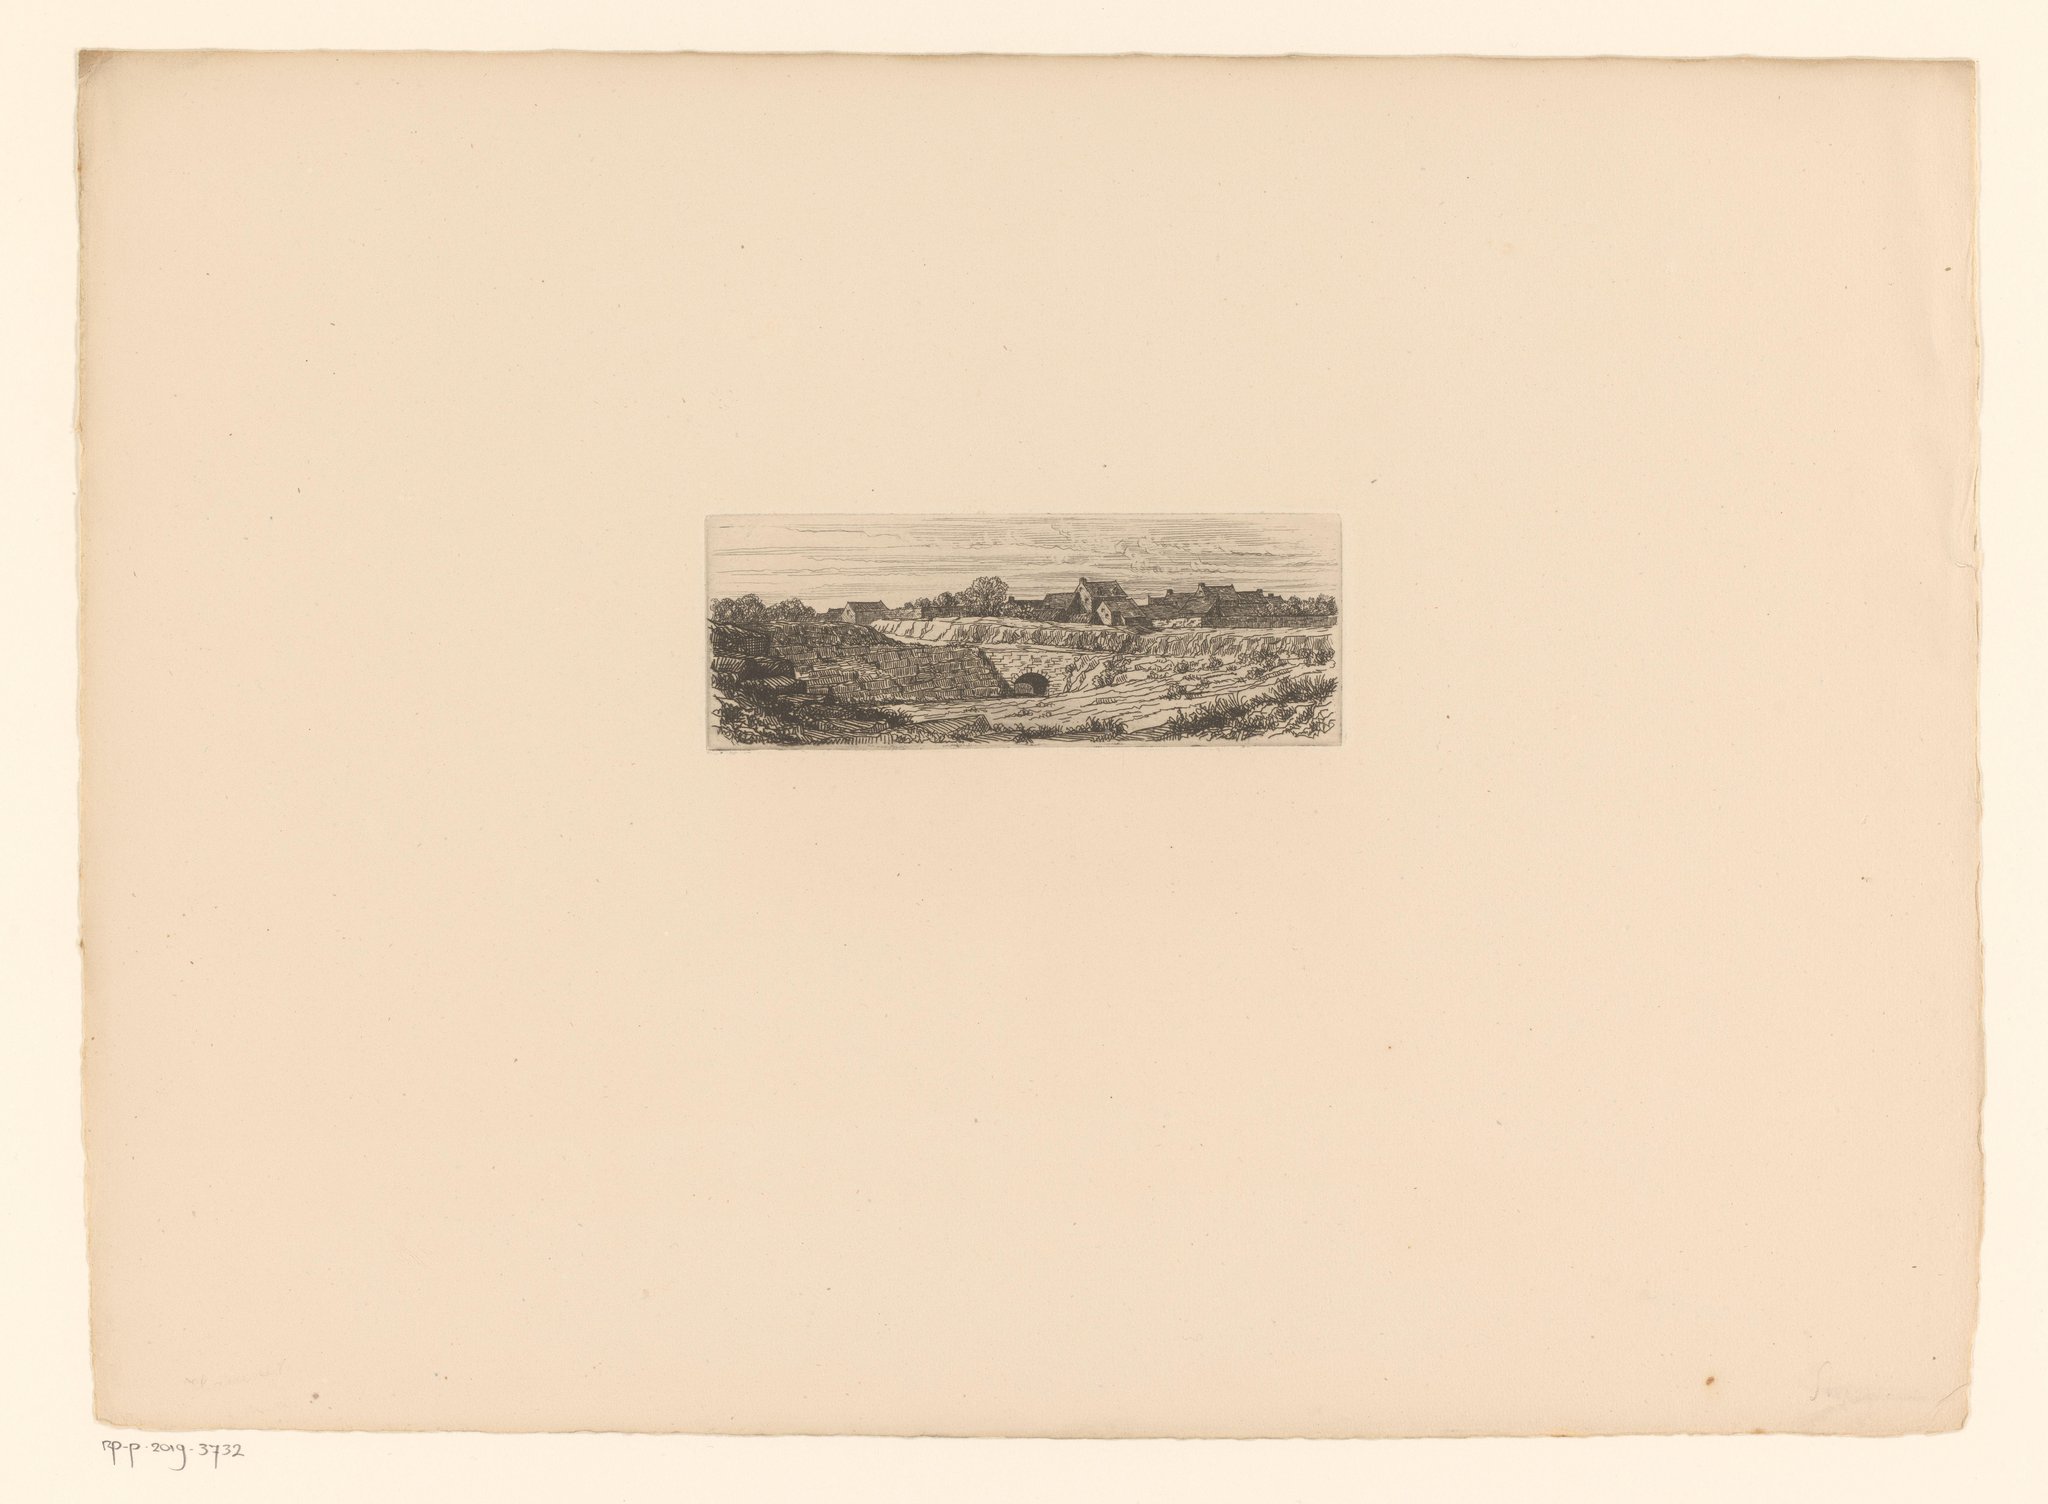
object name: print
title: Album d'eaux-fortes originales et inédites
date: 1875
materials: paper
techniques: etching, intaglio, retroussage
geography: brussels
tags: prospect of village, silhouette of village, fortifications, military engineering